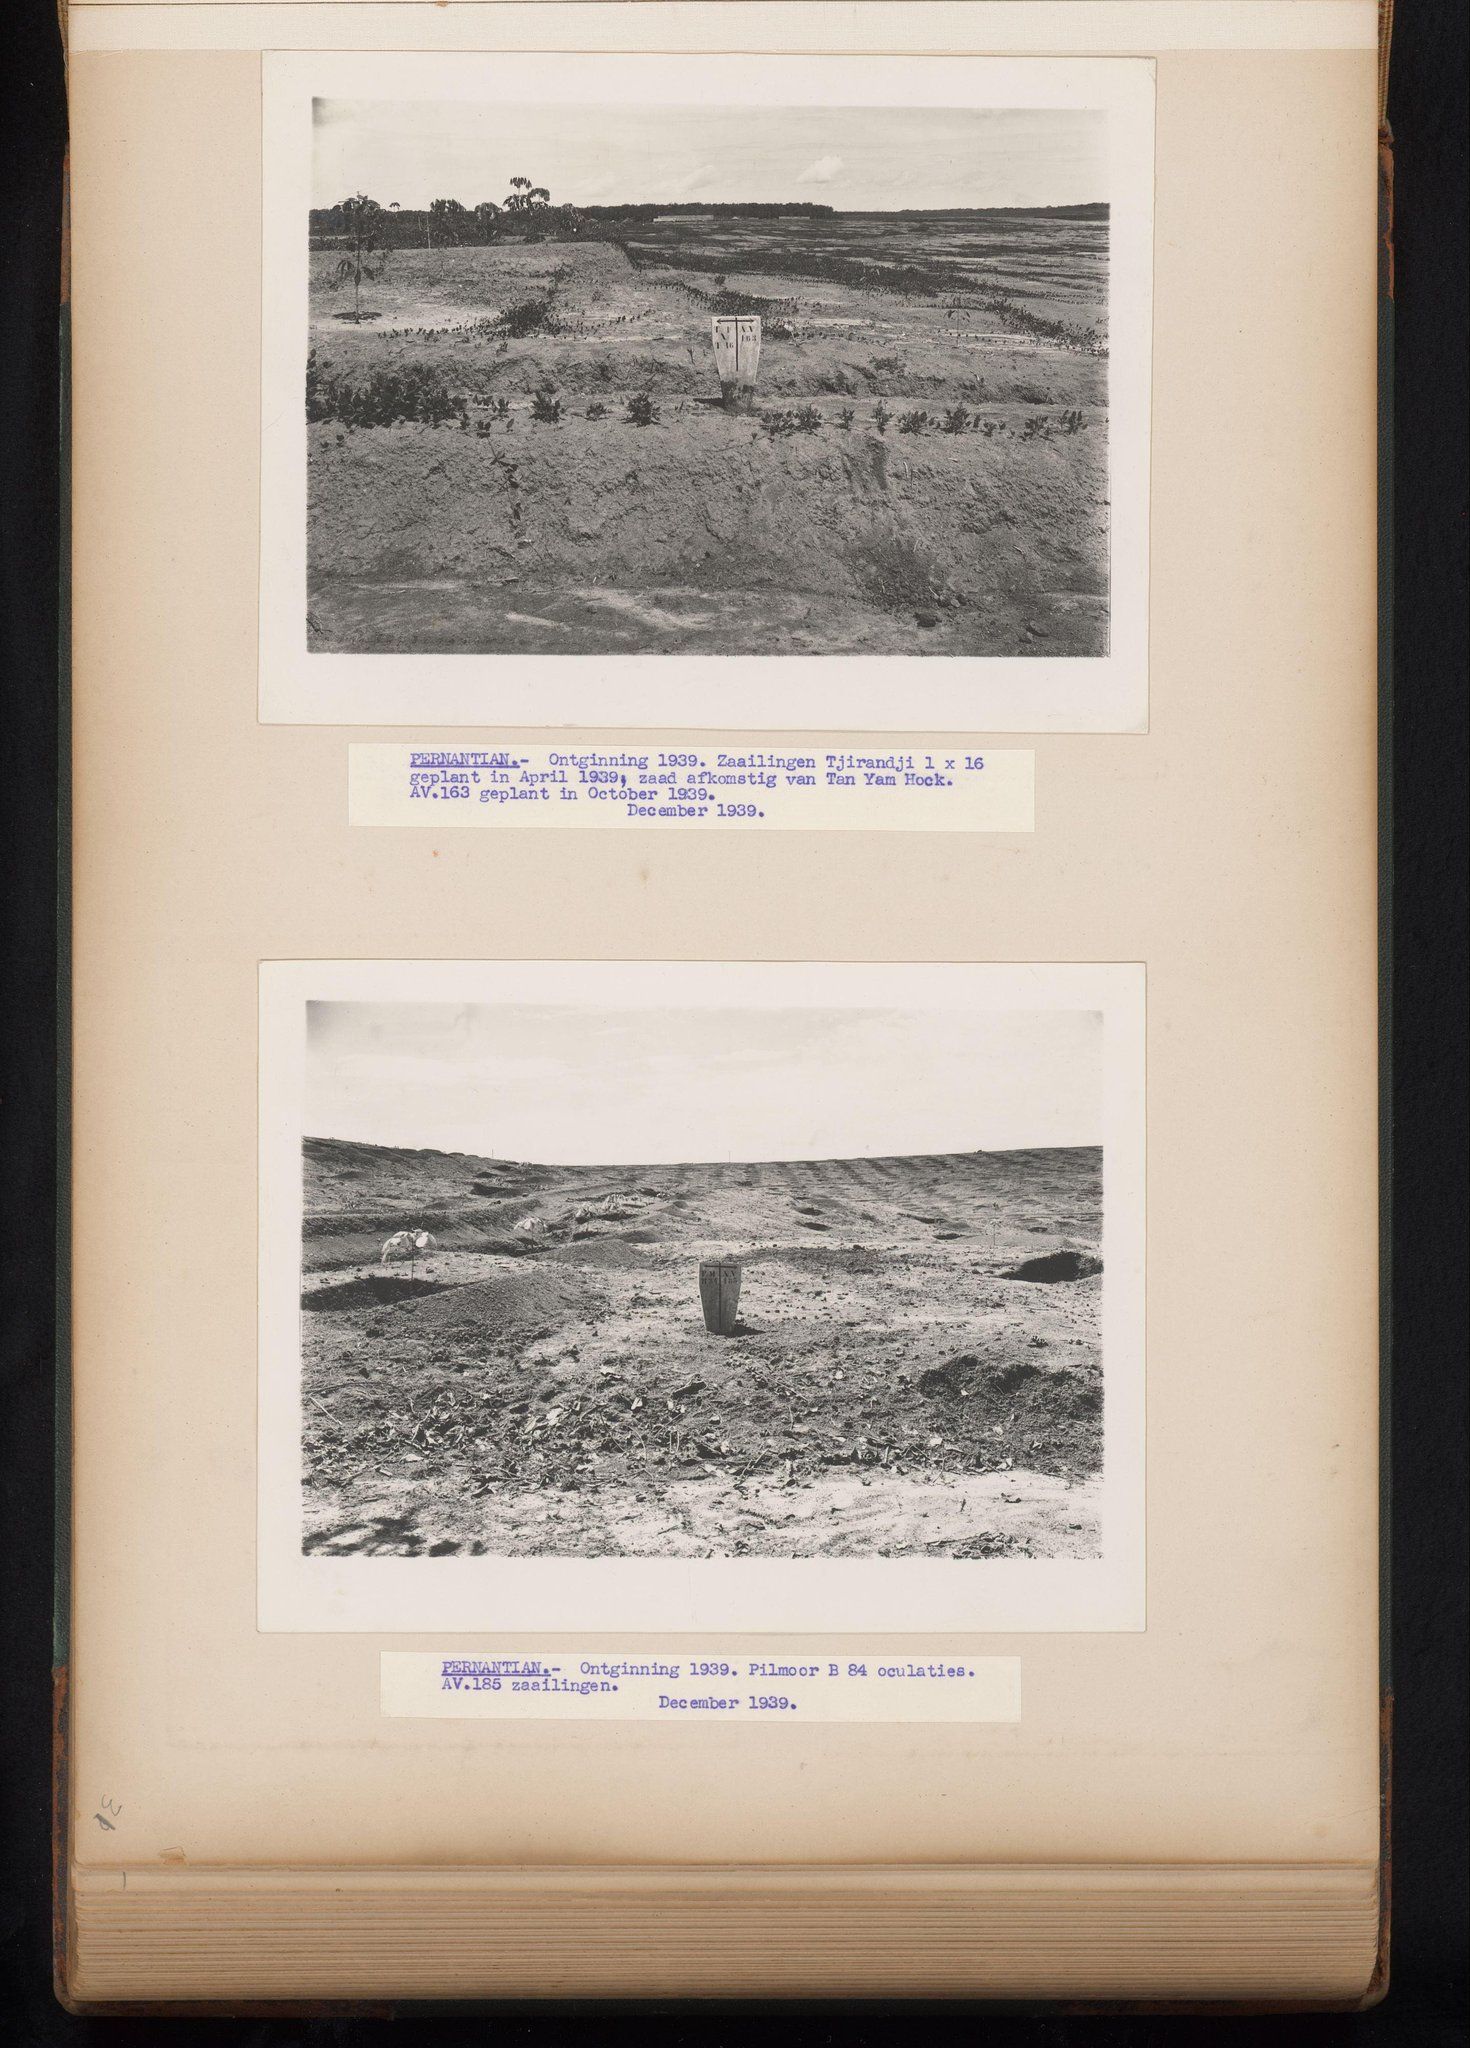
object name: photograph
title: Ontginning op Pernantian, 1939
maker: Anonymous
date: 1912-1939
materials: cardboard, photographic support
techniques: gelatin silver print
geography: sumatra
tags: plantation, (non-fruit) products of plants or trees: rubber, sumatra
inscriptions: inscription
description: Blad met twee foto's van ontginning nieuwe akkers met rubberbomen op Pernantian, december 1939. Met etiketten met onderschriften onder de foto's. Onderdeel van het fotoalbum over de plantages Pernantian en Brussel van de Sumatra Caoutchouc Maatschappij op de Oostkust van Sumatra in de jaren 1935-1939.